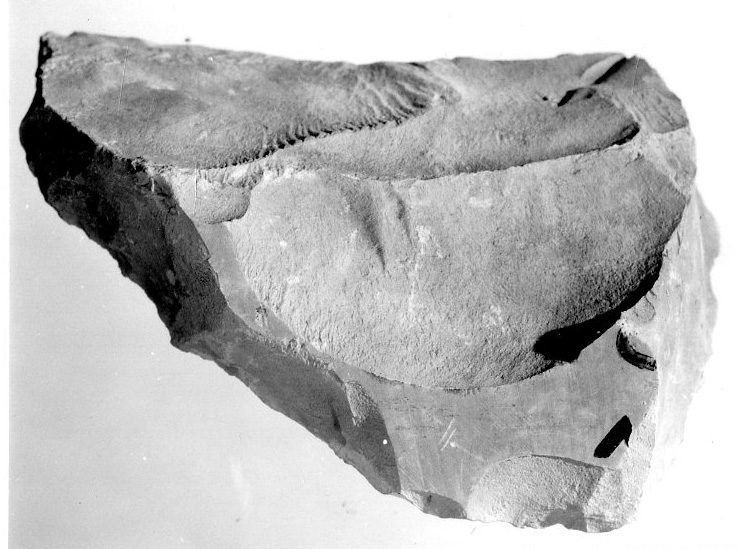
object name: relief fragment, tomb of meketre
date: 1981-1975 BCE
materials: limestone, paint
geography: egypt